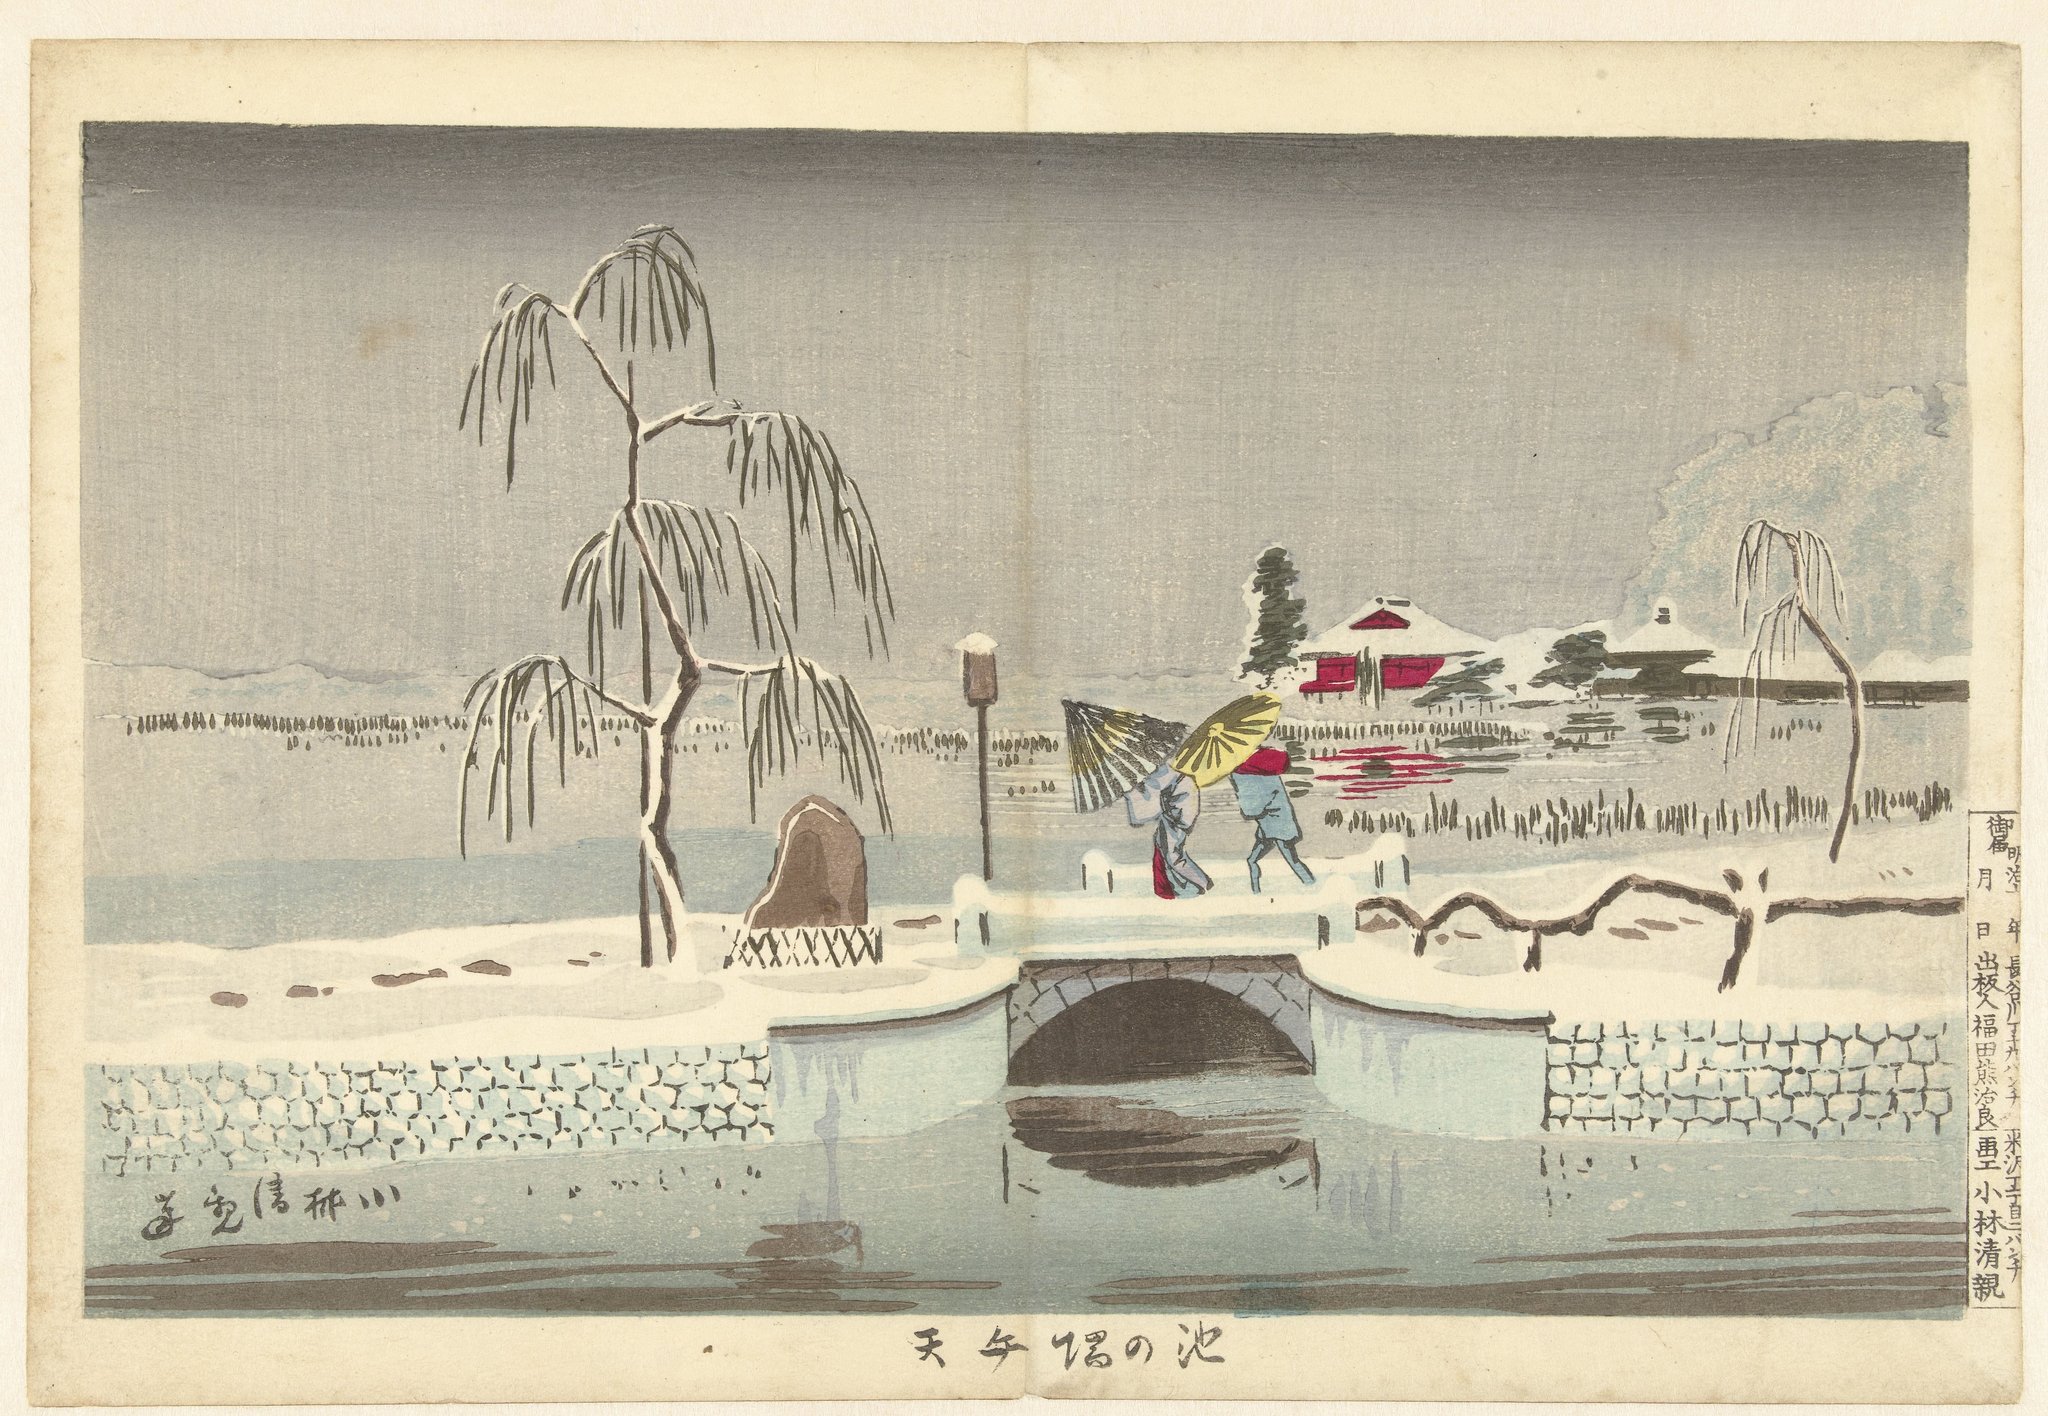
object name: print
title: De rand van de vijver bij het Benten heiligdom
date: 1877-1882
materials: paper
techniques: woodcut, nishiki e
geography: tokyo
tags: umbrella, snow, landscapes (+ landscape with figures, staffage)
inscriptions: collector's mark: Lugt 2760, collector's mark: Lugt 2228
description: Winterlandschap met twee personen lopend onder paraplu over een bruggetje bij de Shinobazu vijver. Op de achtergrond het rode Benten heiligdom.